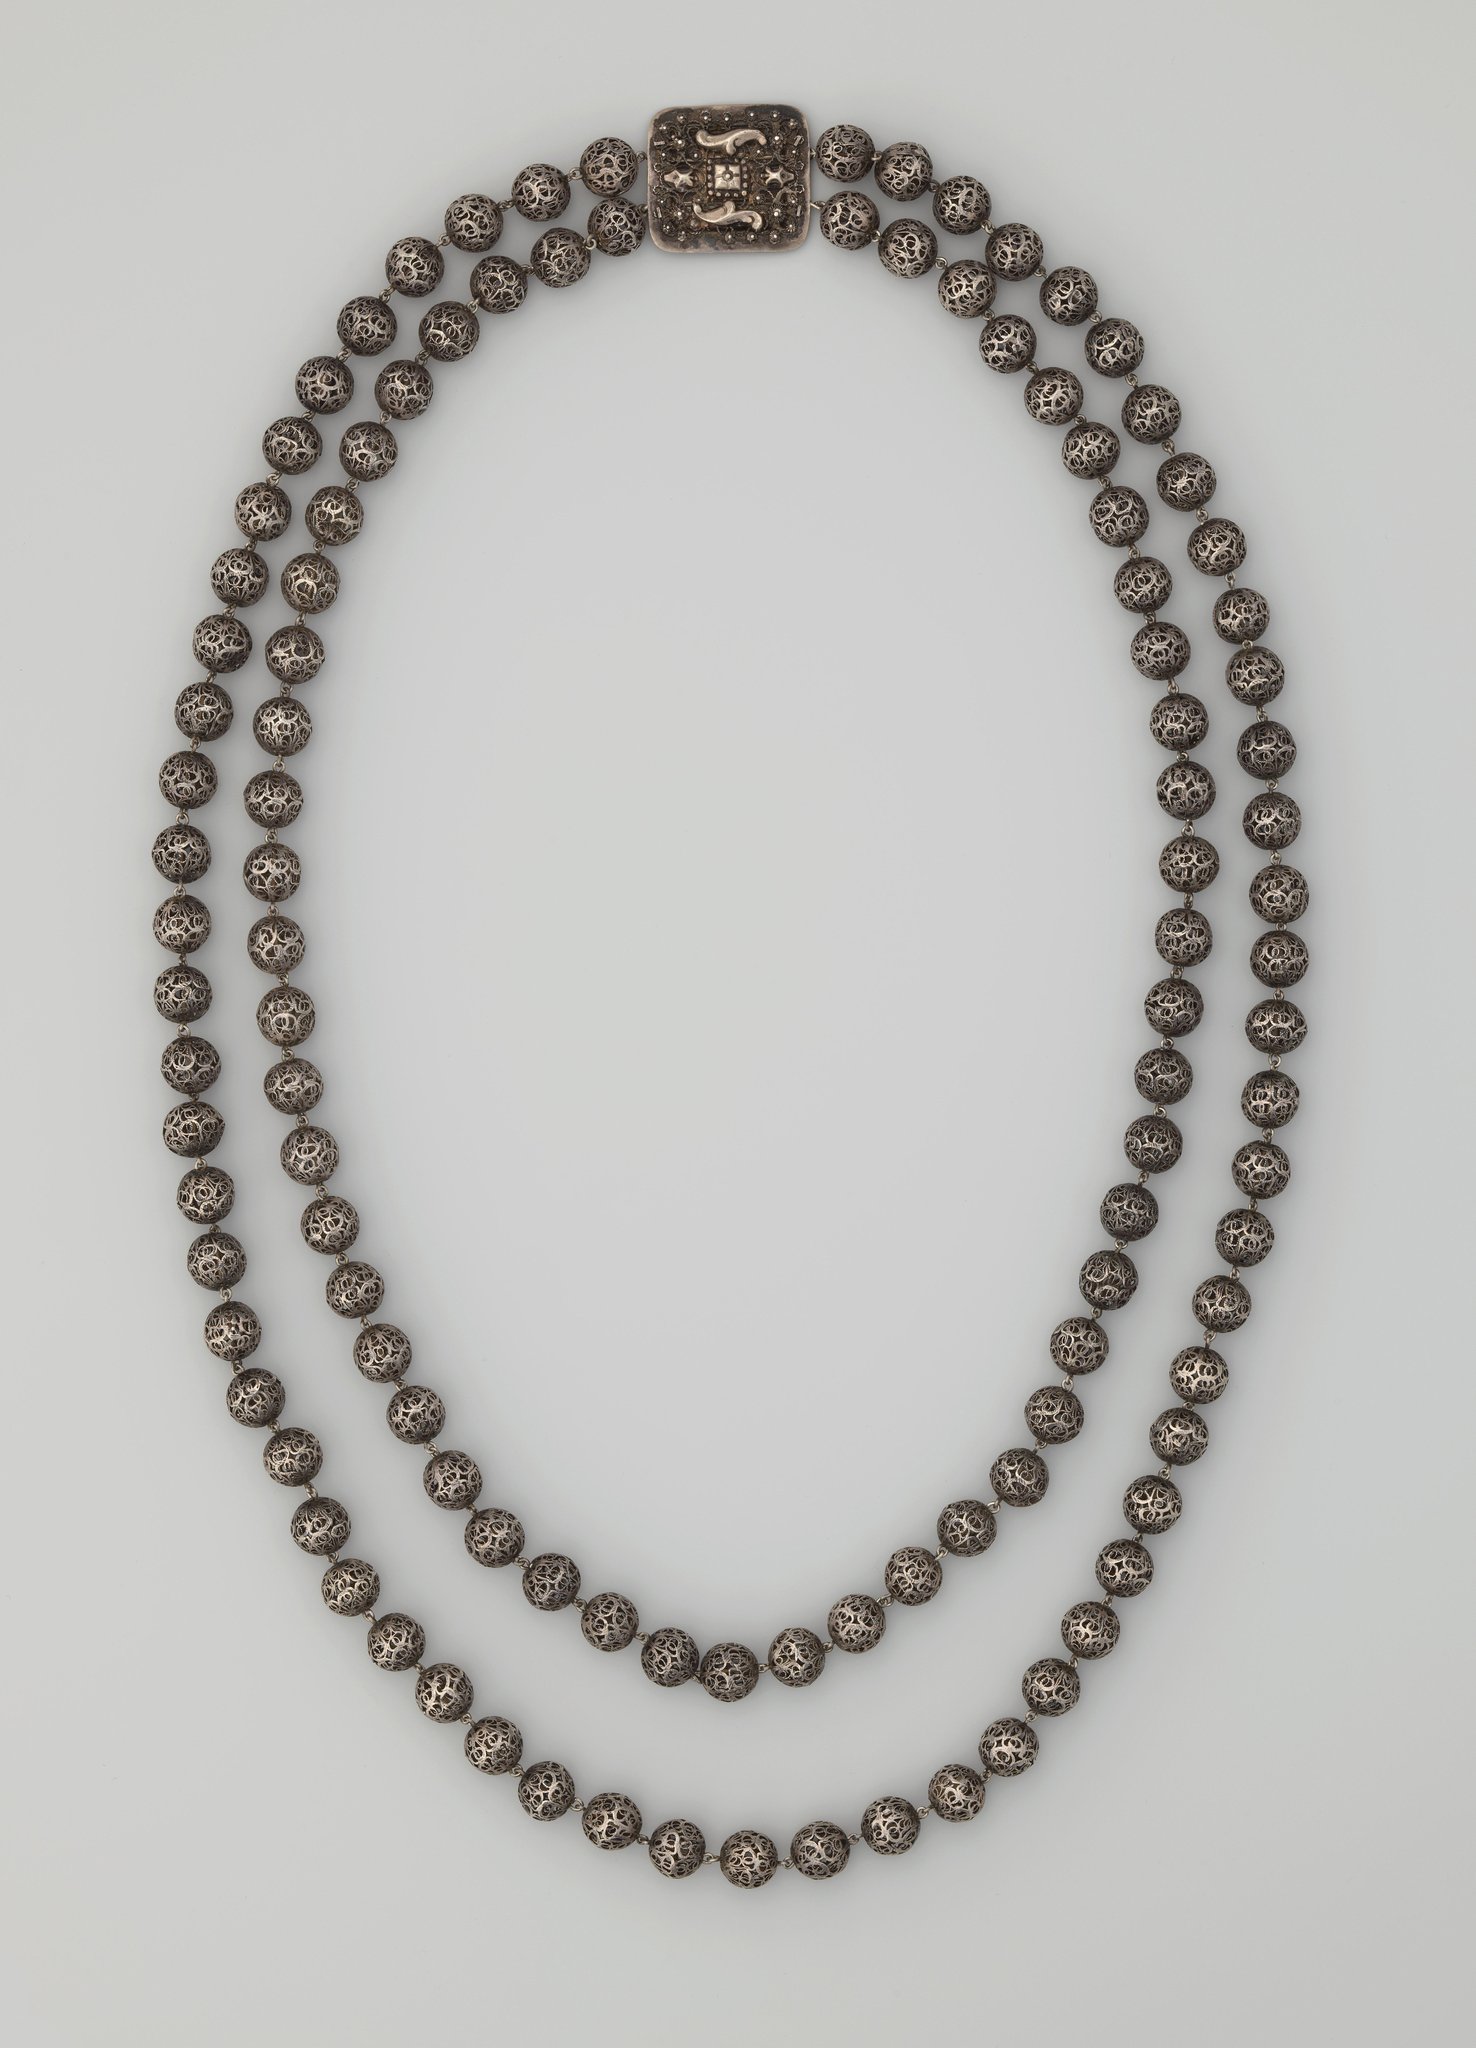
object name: necklace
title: Halssieraad van zilver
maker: willem johanes van gastel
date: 1900-1910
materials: silver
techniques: filigree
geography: breda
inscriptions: maker's mark, alloy mark: ‘oud zwaard’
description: Samengesteld halssieraad van eerste en tweede gehalte zilver. De oudere slotplaat is versierd met spinnetjes en twee maal een hoorn des overvloeds. De kralen zijn van bollen van zilverdraad en zijn met gesloten oogjes aan de slotplaat bevestigd.